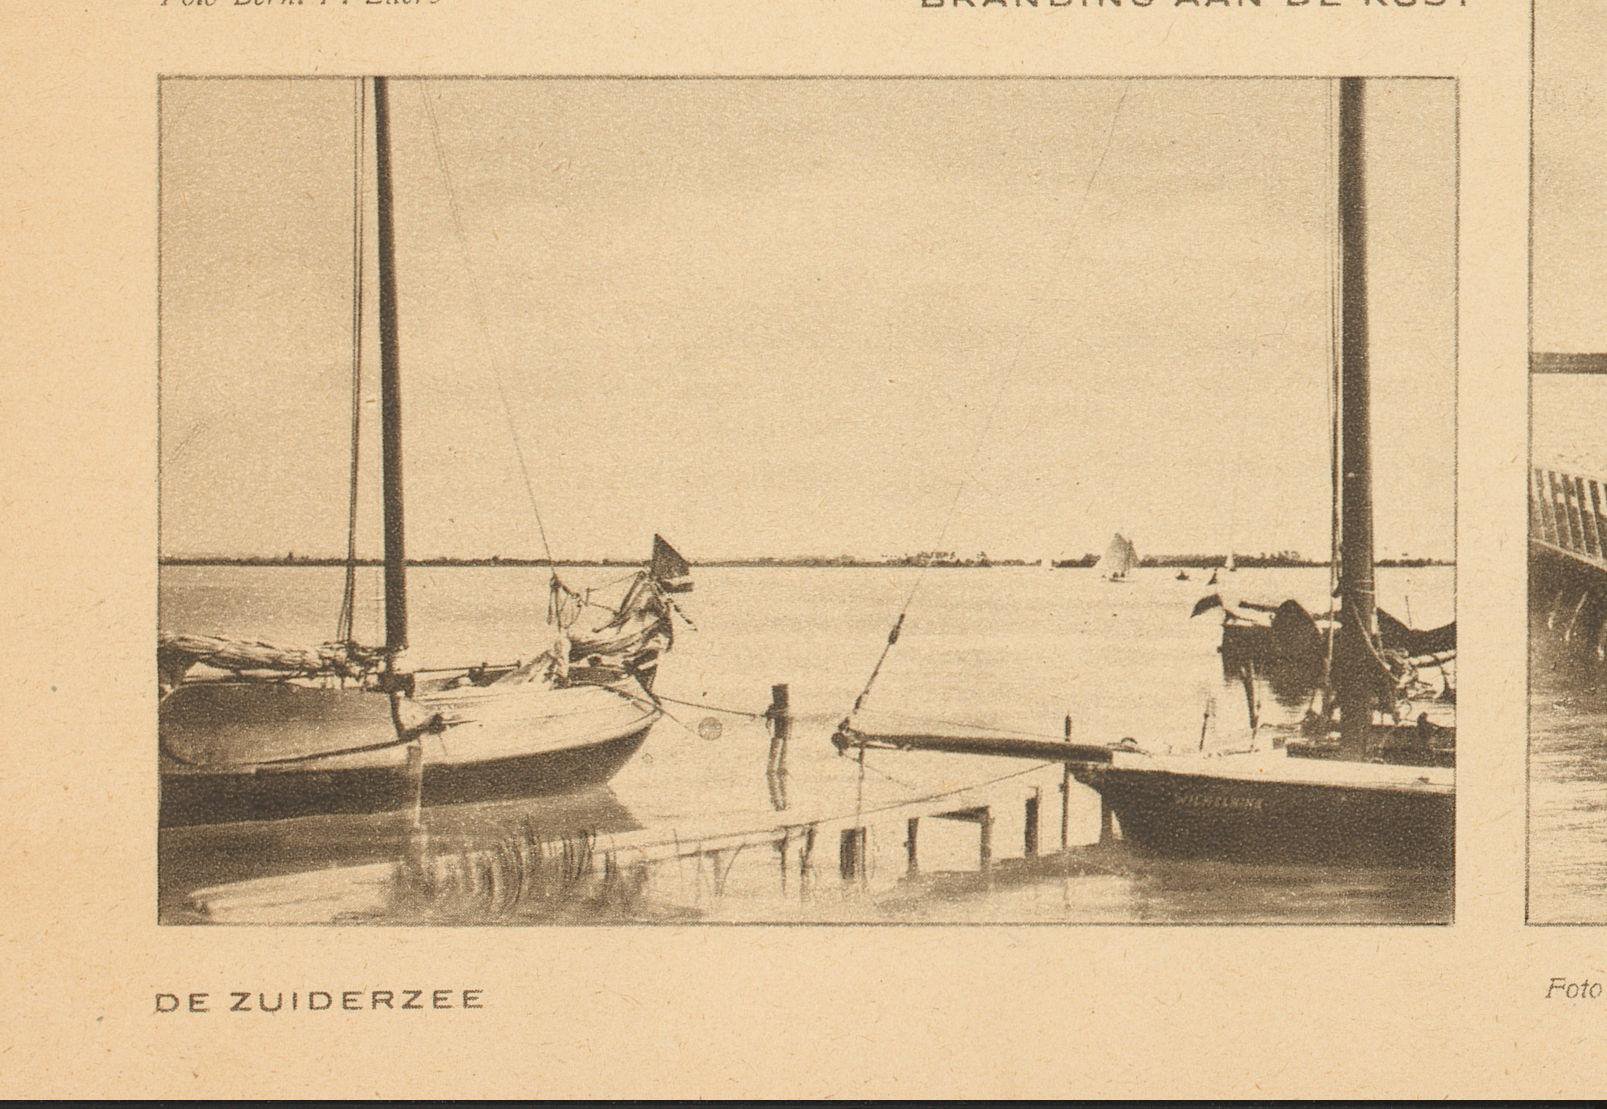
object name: album leaf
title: Gezicht op de Zuiderzee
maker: Anonymous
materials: paper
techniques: rotogravure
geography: leiden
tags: sea, zuiderzee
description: Deze prent maakt deel uit van een album.